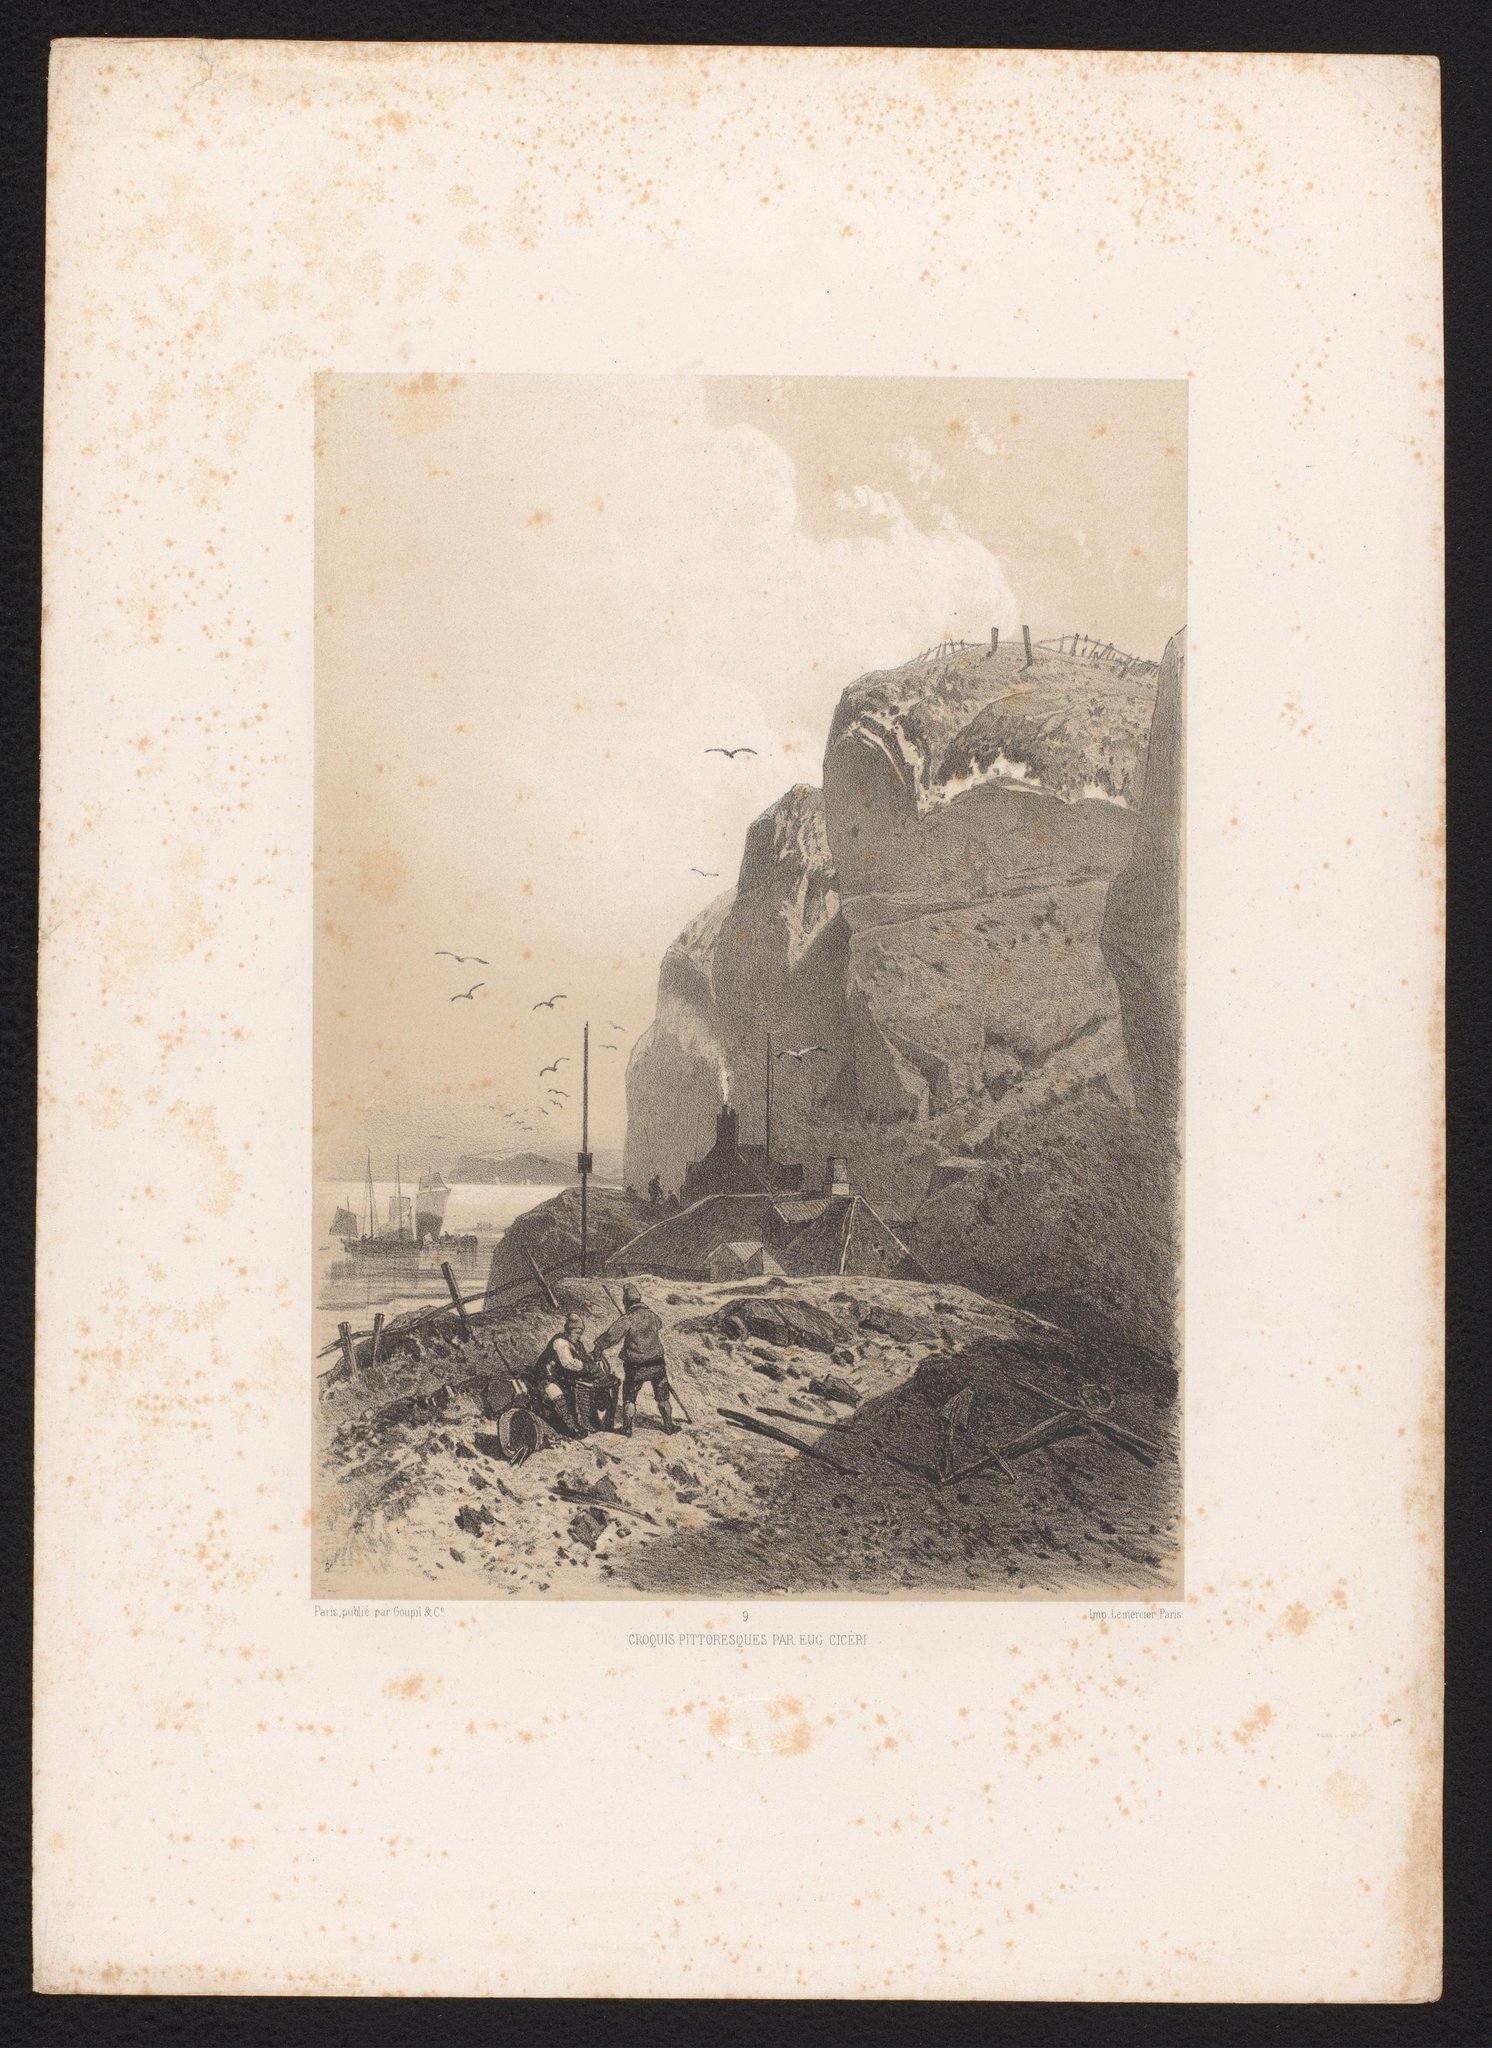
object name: print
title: Pittoreske landschappen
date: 1854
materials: paper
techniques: tone lithography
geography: paris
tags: coastal cliff or crag, prospect of village, silhouette of village (+ city(-scape) with figures, staffage), sea and coastal fishery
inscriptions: check stamp: Lugt 1090